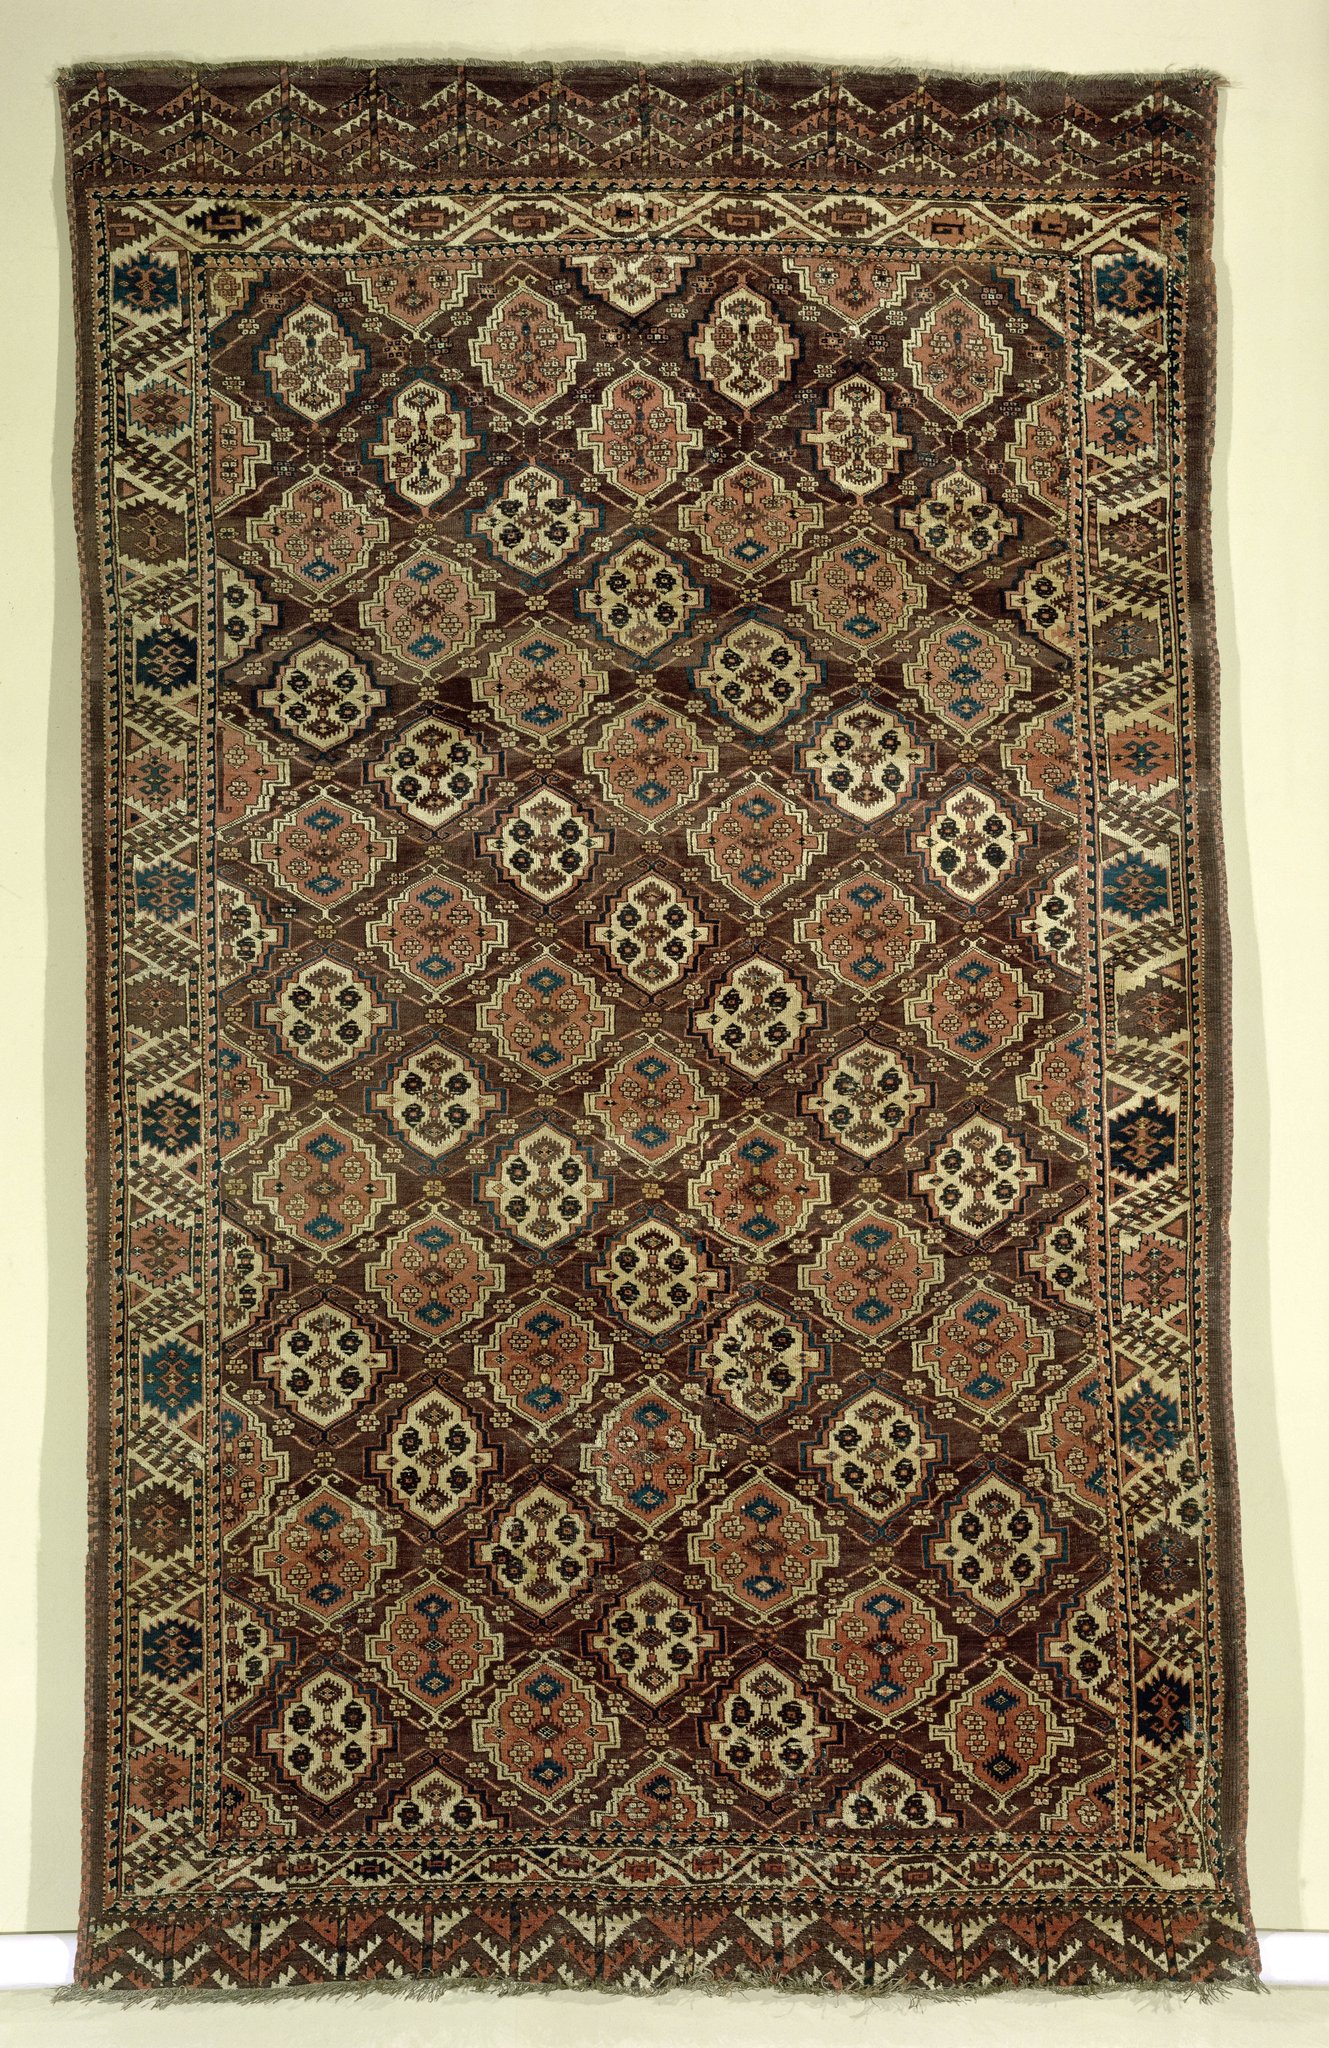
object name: oriental rug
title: Oosters tapijt met rasterwerk en bloemen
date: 1800-1975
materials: wool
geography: north turkmenistan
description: Oosters tapijt, rasterwerk-bloemenkleed, Tsoudoren volk. In het middenveld een rasterpatroon van bliksemschichtlijnen met margrieten tegen een aubergine fond. In de mazen cartouches met bloemen. Rand boven en onder viervoudig, aan de zijkanten drievoudig.